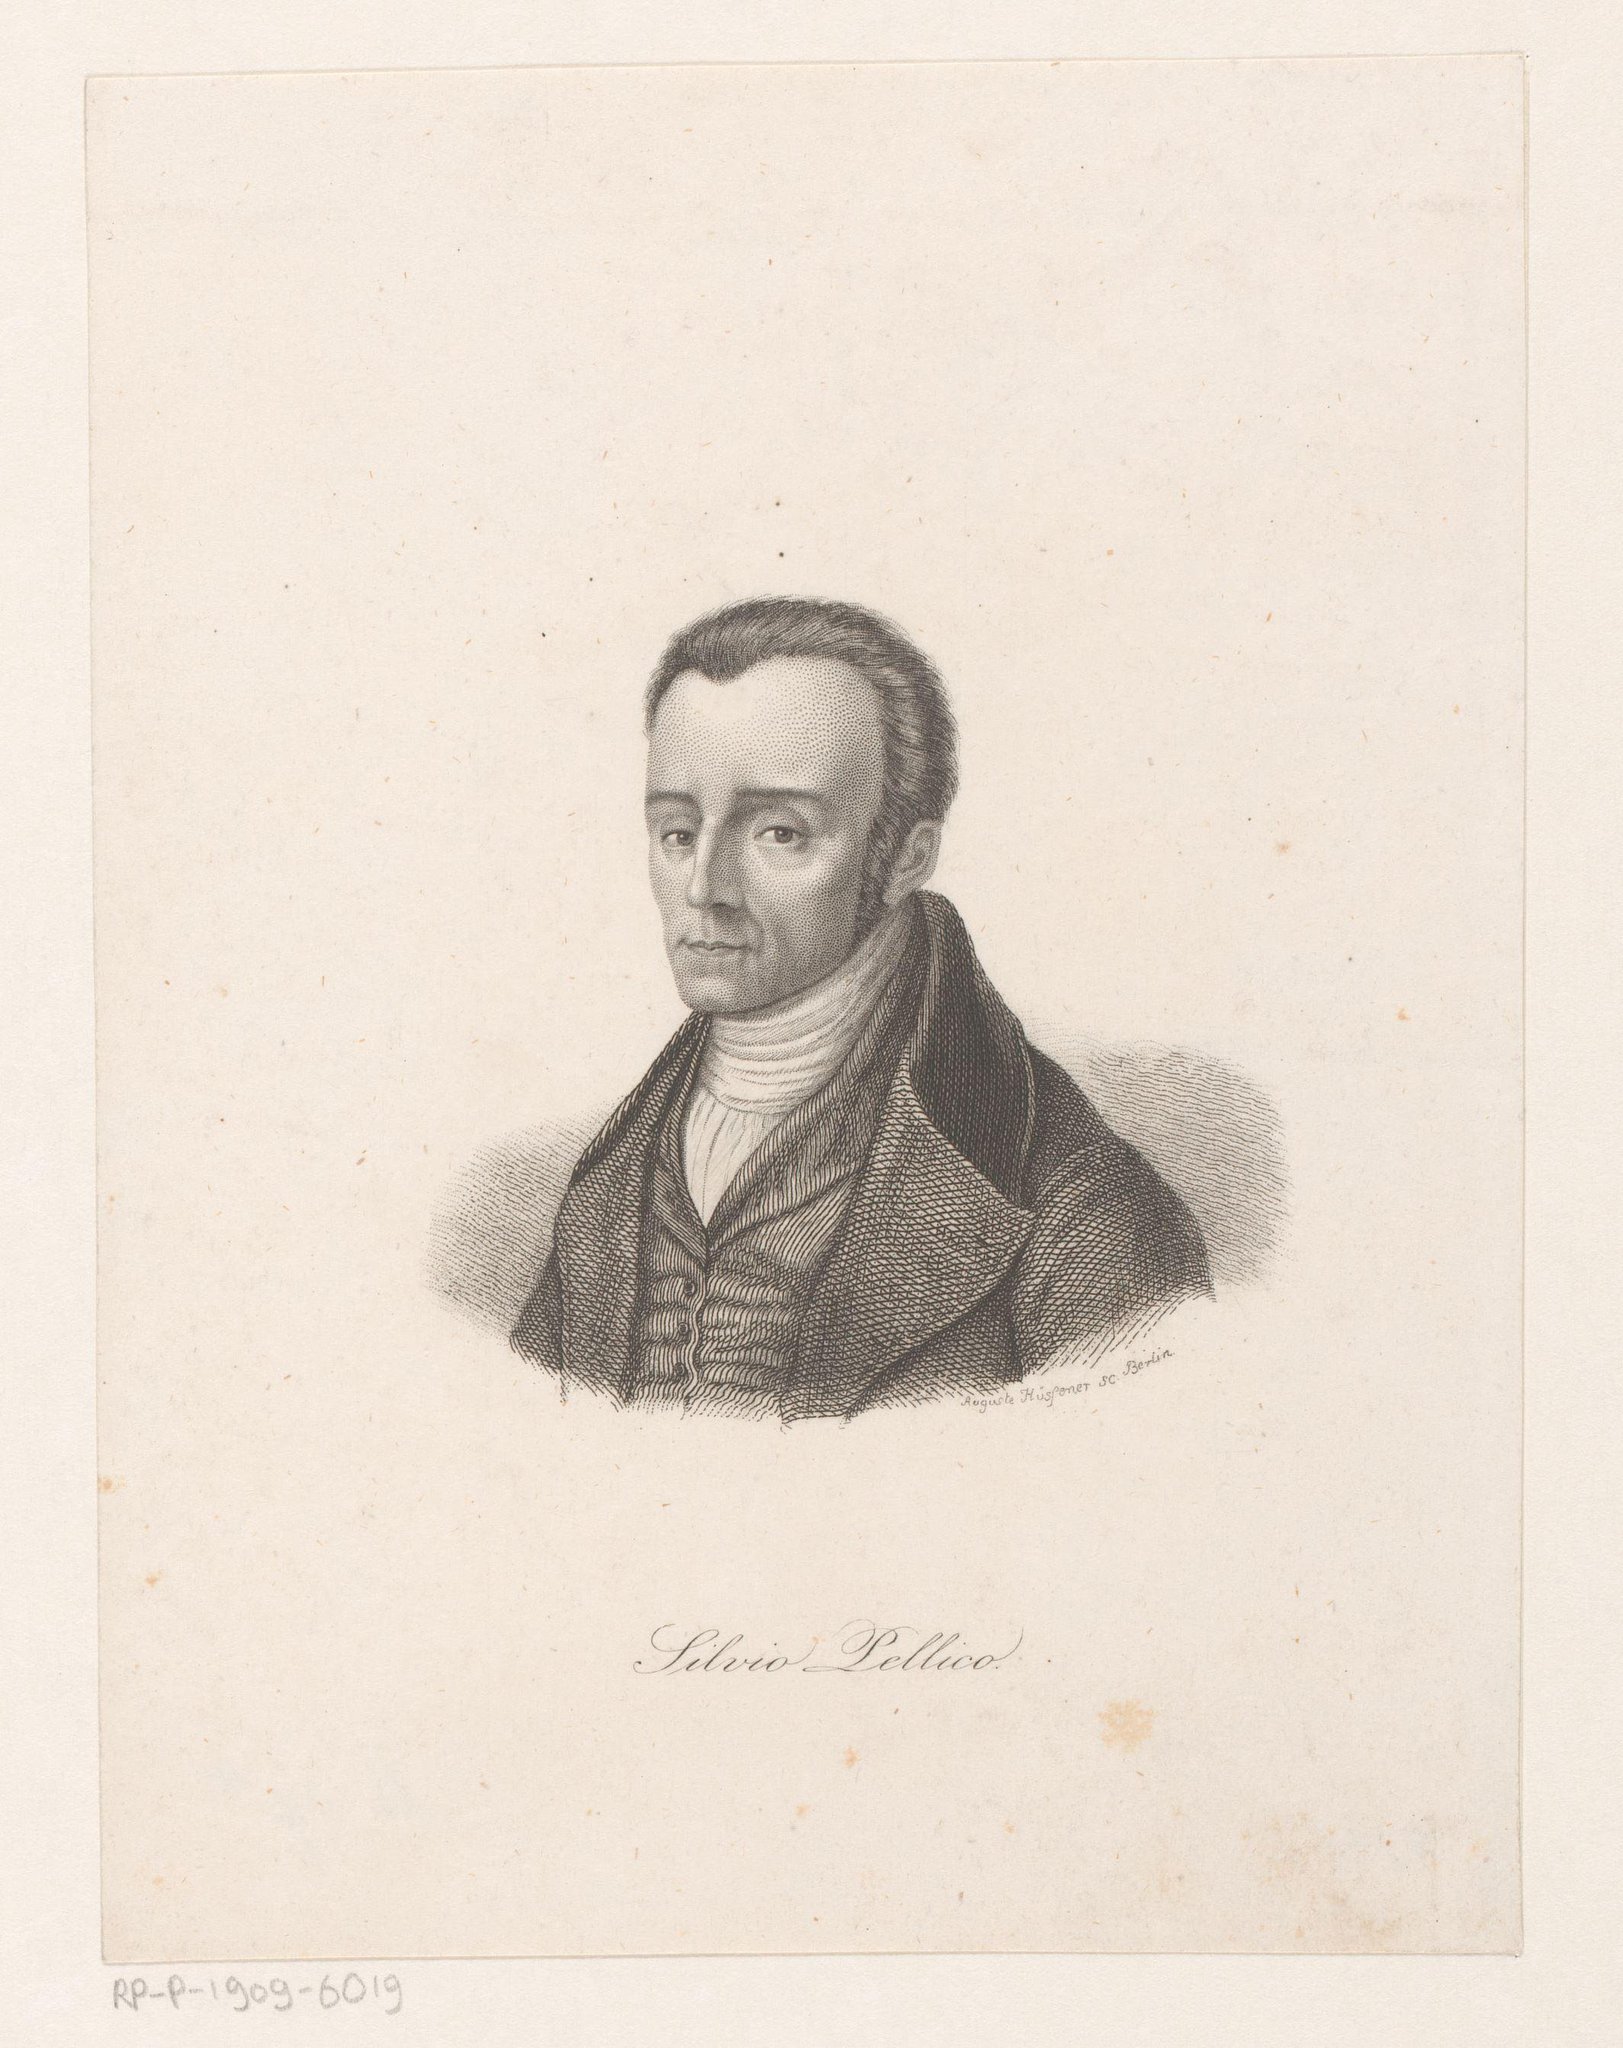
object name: print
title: Portret van Silvio Pellico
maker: auguste hüssener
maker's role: print maker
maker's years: 1789-1877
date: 1799-1877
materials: paper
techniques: etching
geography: berlin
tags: portrait of a writer (+ arts of the stage), historical persons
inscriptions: collector's mark: Lugt 2228